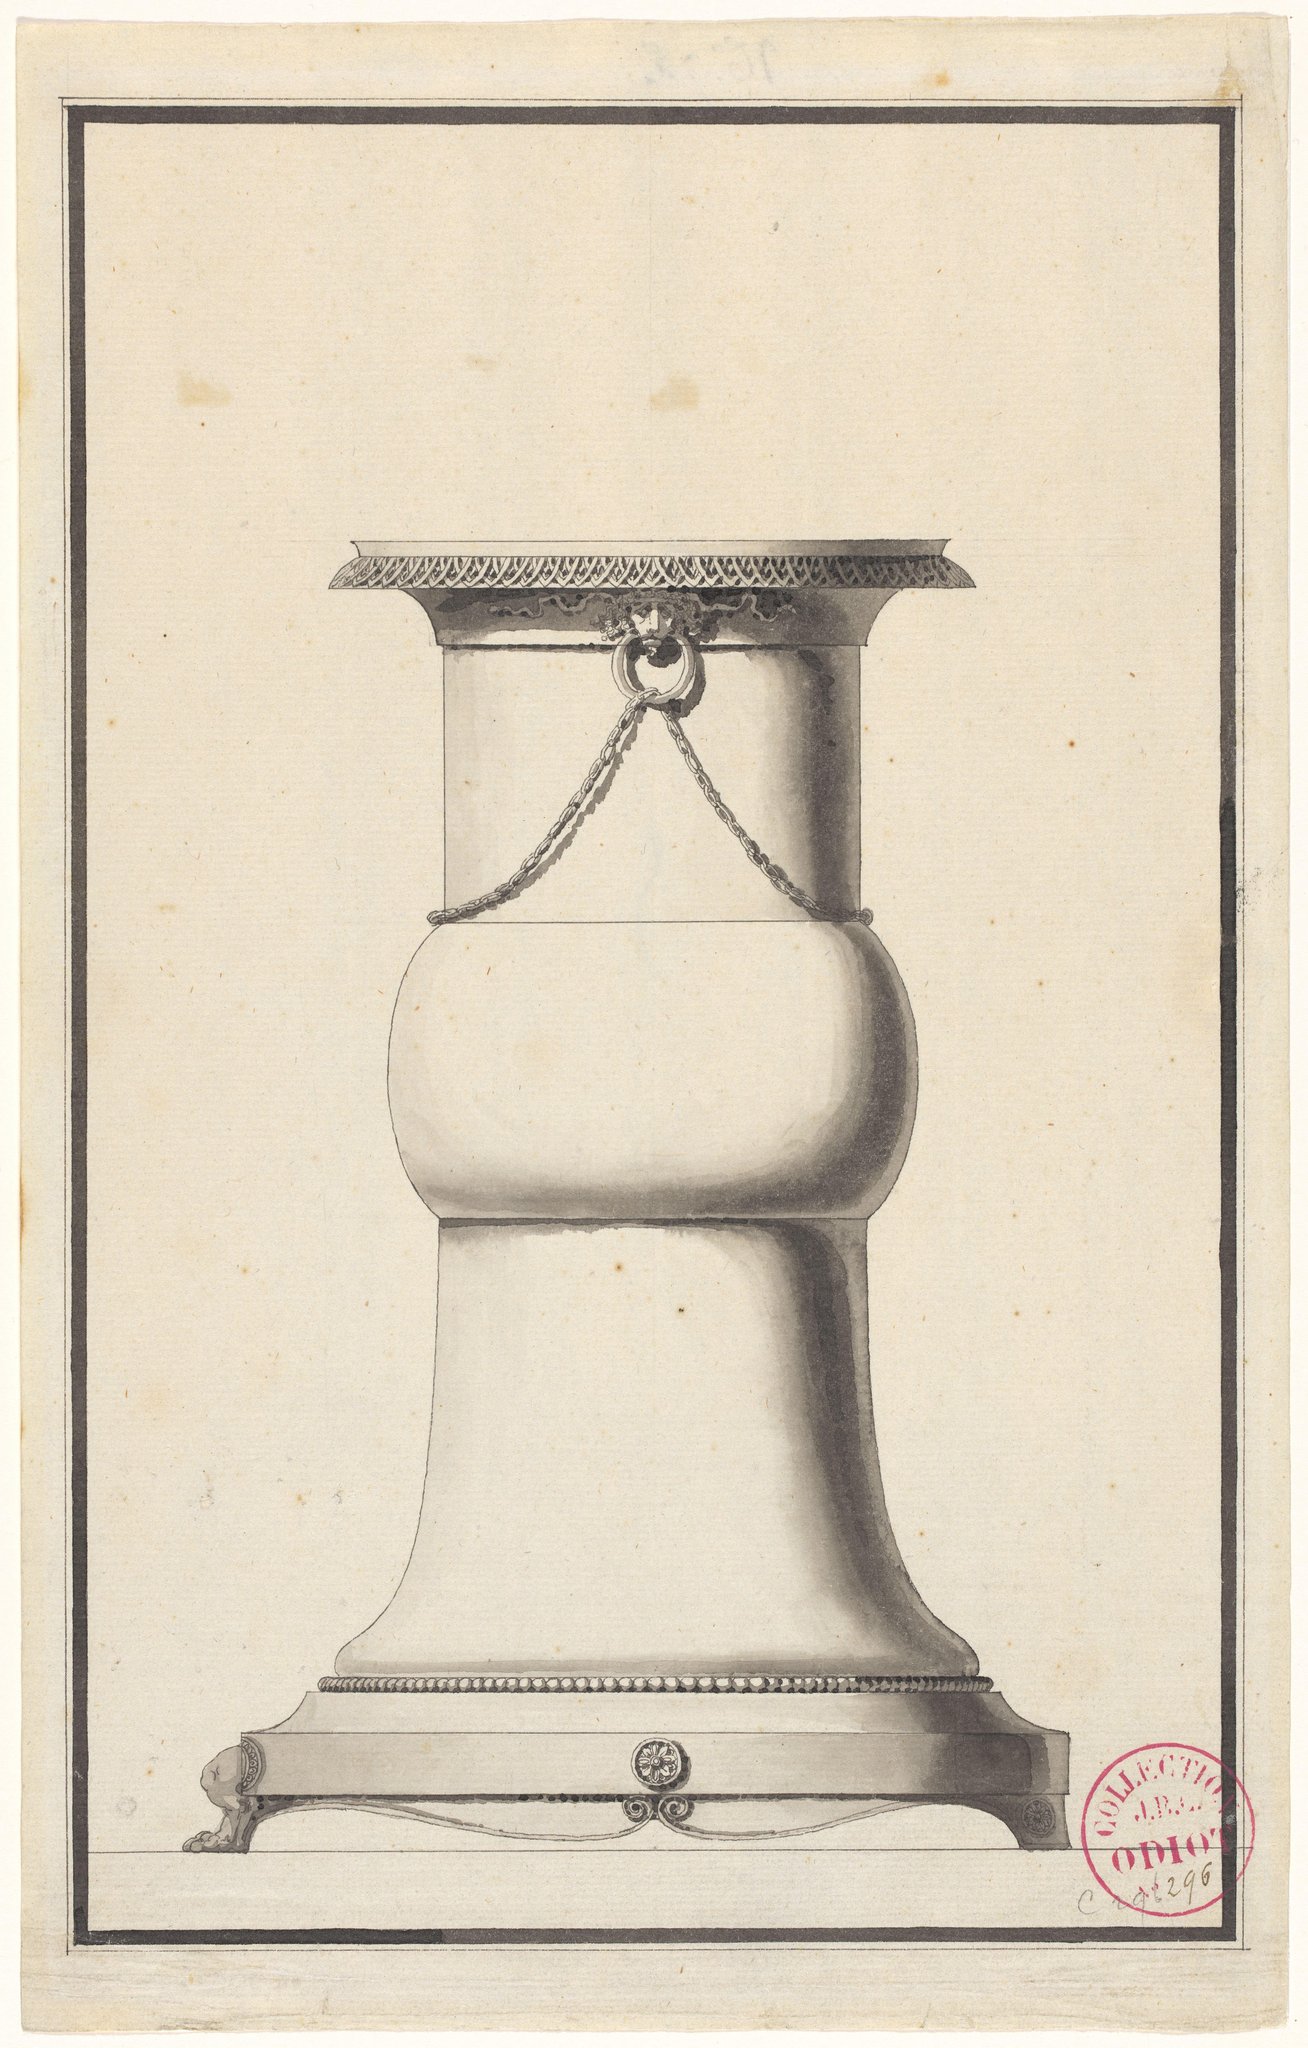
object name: design drawing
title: Ontwerp voor de verguld bronzen montuur van een Chinees porseleinen vaas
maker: jean guillaume moitte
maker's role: print maker, sculptor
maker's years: 1746-1810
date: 1790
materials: graphite, ink, paper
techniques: brush, pen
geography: paris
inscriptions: number: ‘C 296’, collector's mark: ‘COLLECTION / J.B.C. / ODIOT / No. 296’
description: Ontwerp voor de verguld bronzen montuur van een Chinees porseleinen vaas, met alternatiefoplossingen voor de voet.